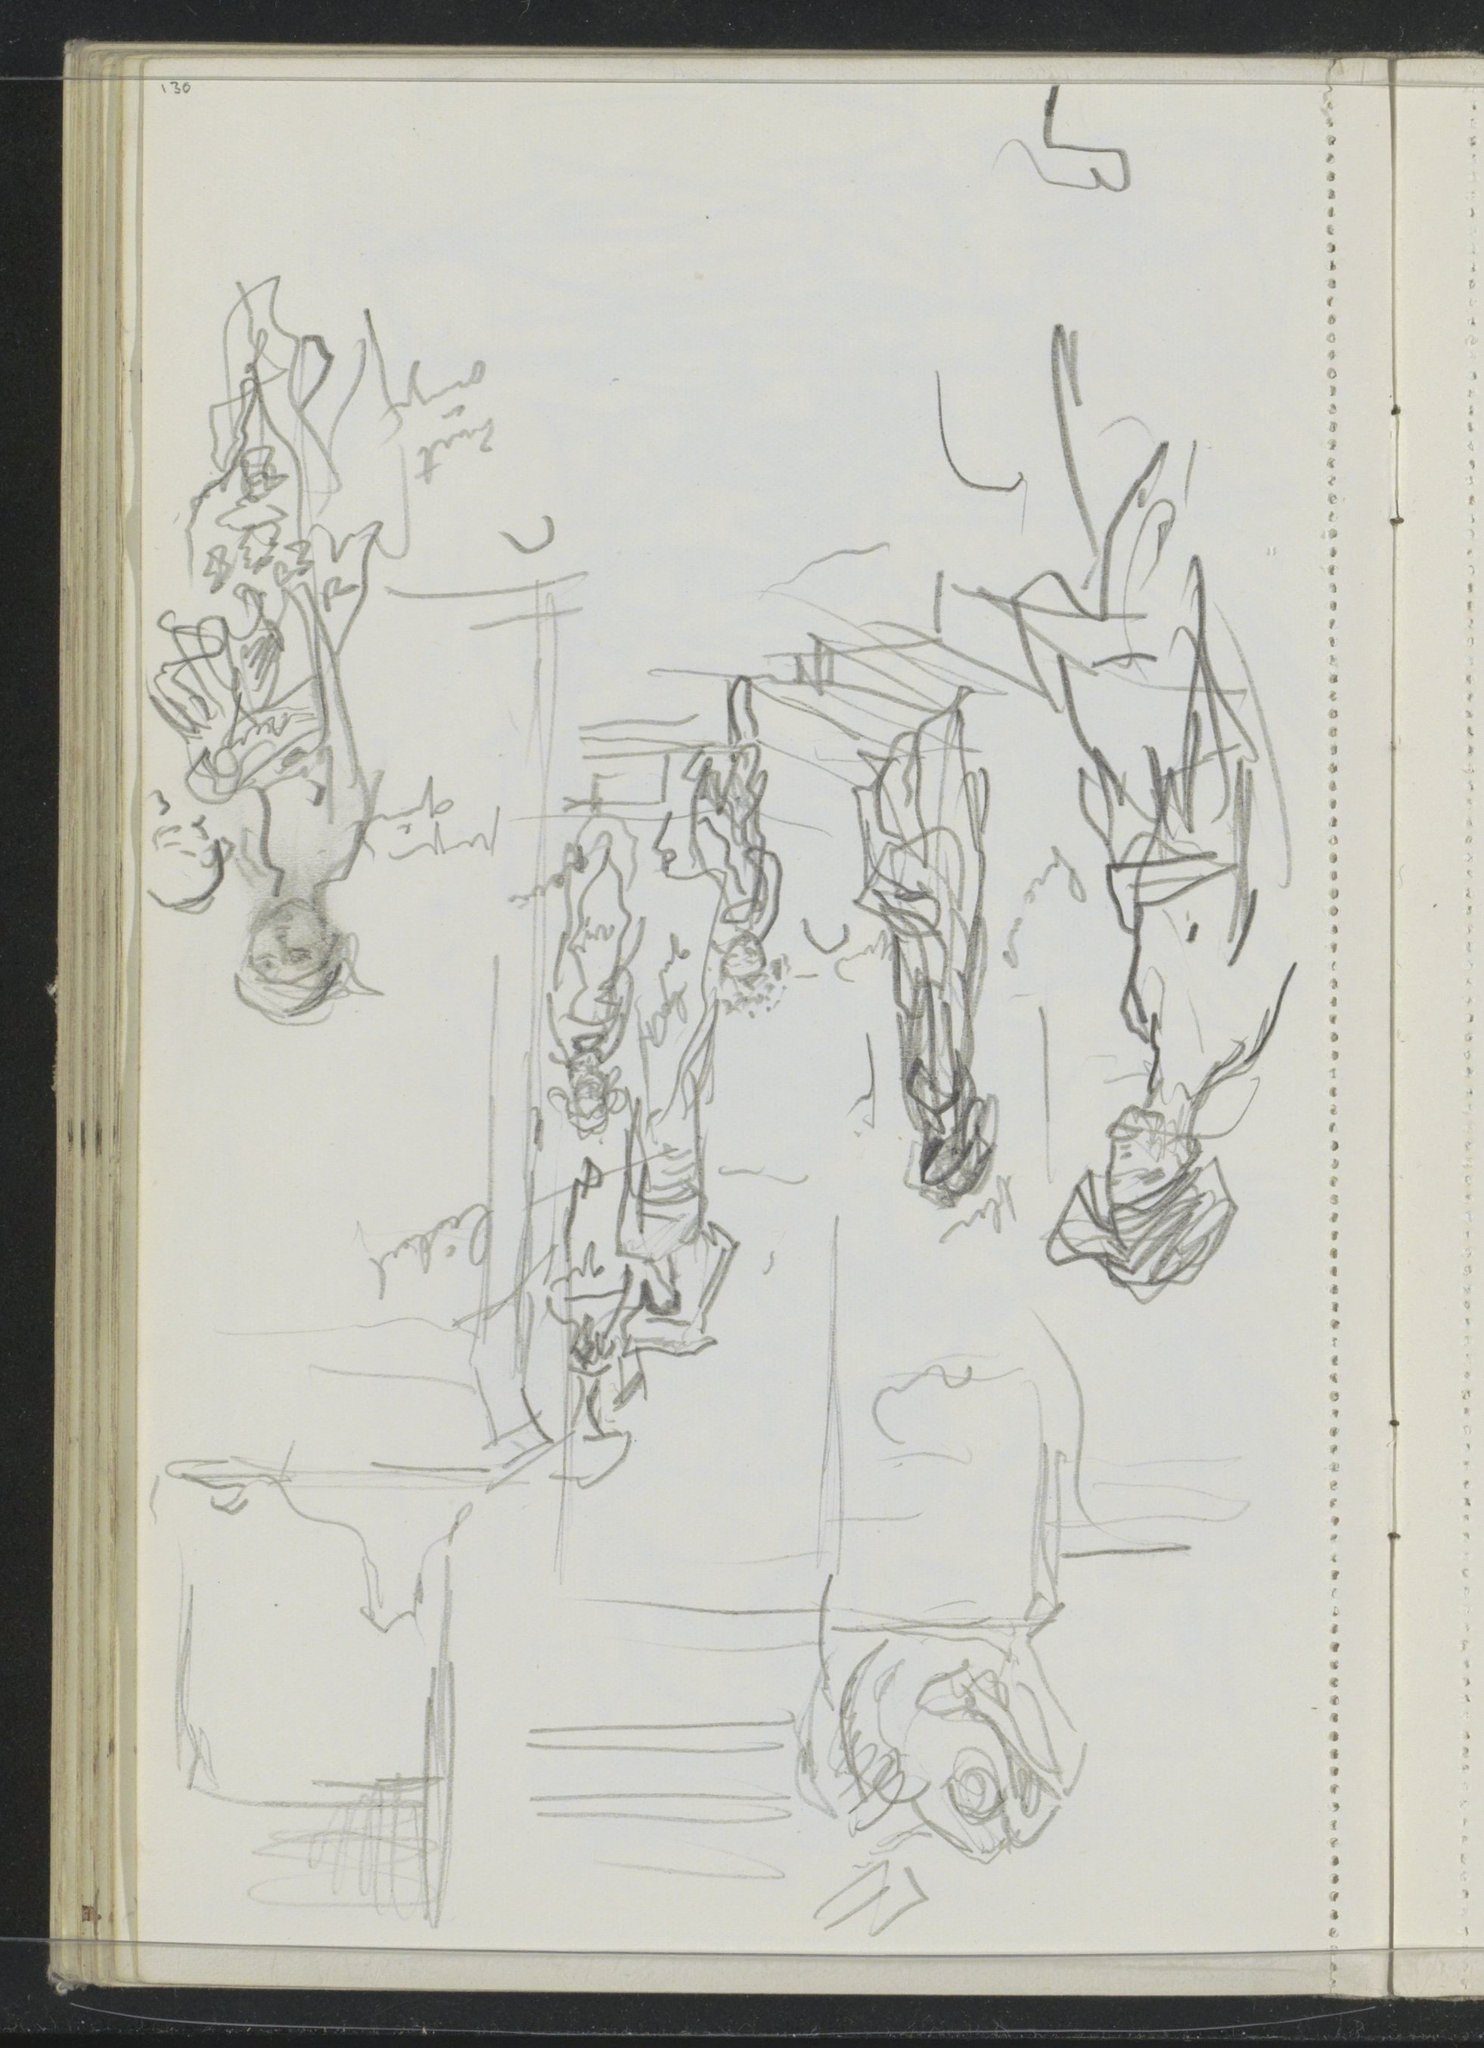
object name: sketchbook leaf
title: Figuren op een tempeltrap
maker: marius bauer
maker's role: draughtsman, print maker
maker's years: 1867-1932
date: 1925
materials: paper, pencil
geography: indonesia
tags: asiatic races and peoples, temple, shrine ~ hinduism, buddhism, jainism, flight of steps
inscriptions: kleurnotitie, handgeschreven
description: Pagina 130 uit een schetsboek met 74 bladen.